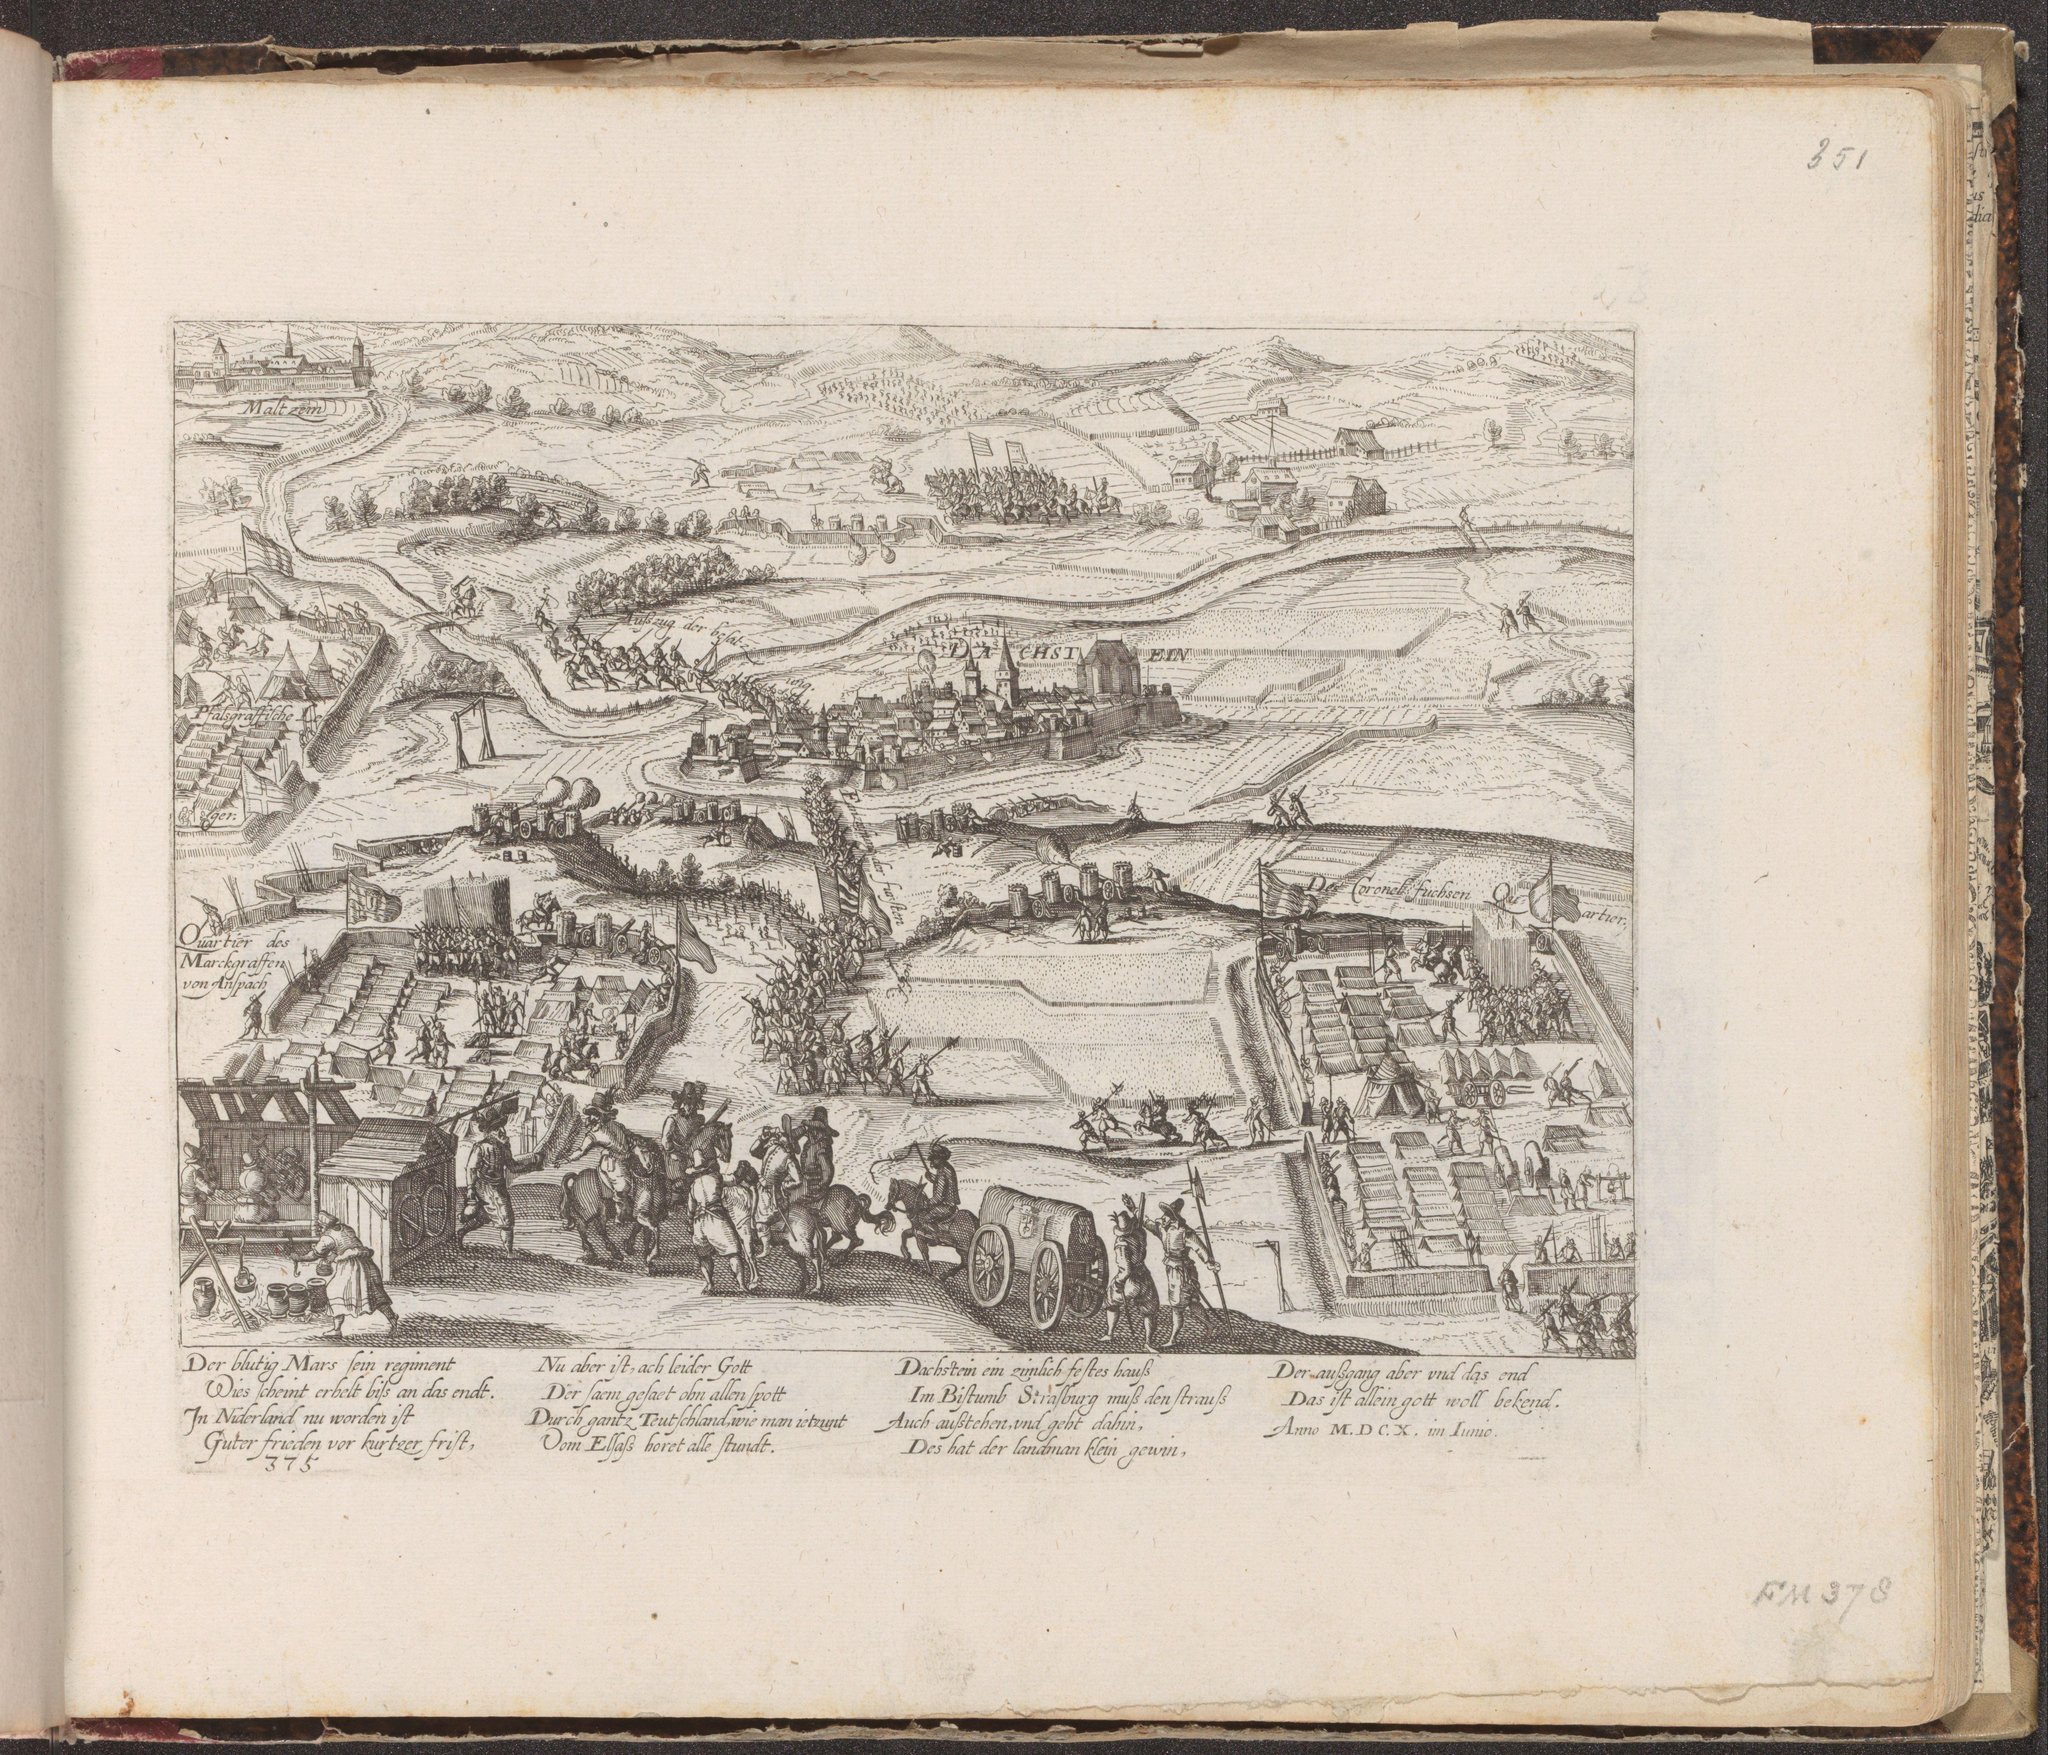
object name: album leaf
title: Serie 10: Nederlandse en Buitenlandse Gebeurtenissen, 1587-1612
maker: frans hogenberg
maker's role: print maker, publisher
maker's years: 1538-1590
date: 1610-1612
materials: paper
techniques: etching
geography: cologne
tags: siege, position war, alsace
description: Beleg van Dachstein in de Elzas, juni 1610. Episode uit de Gulik-Kleefse kwestie. Met onderschrift van 16 regels in het Duits. Linksonder genummerd: 375. De prent maakt deel uit van een album.